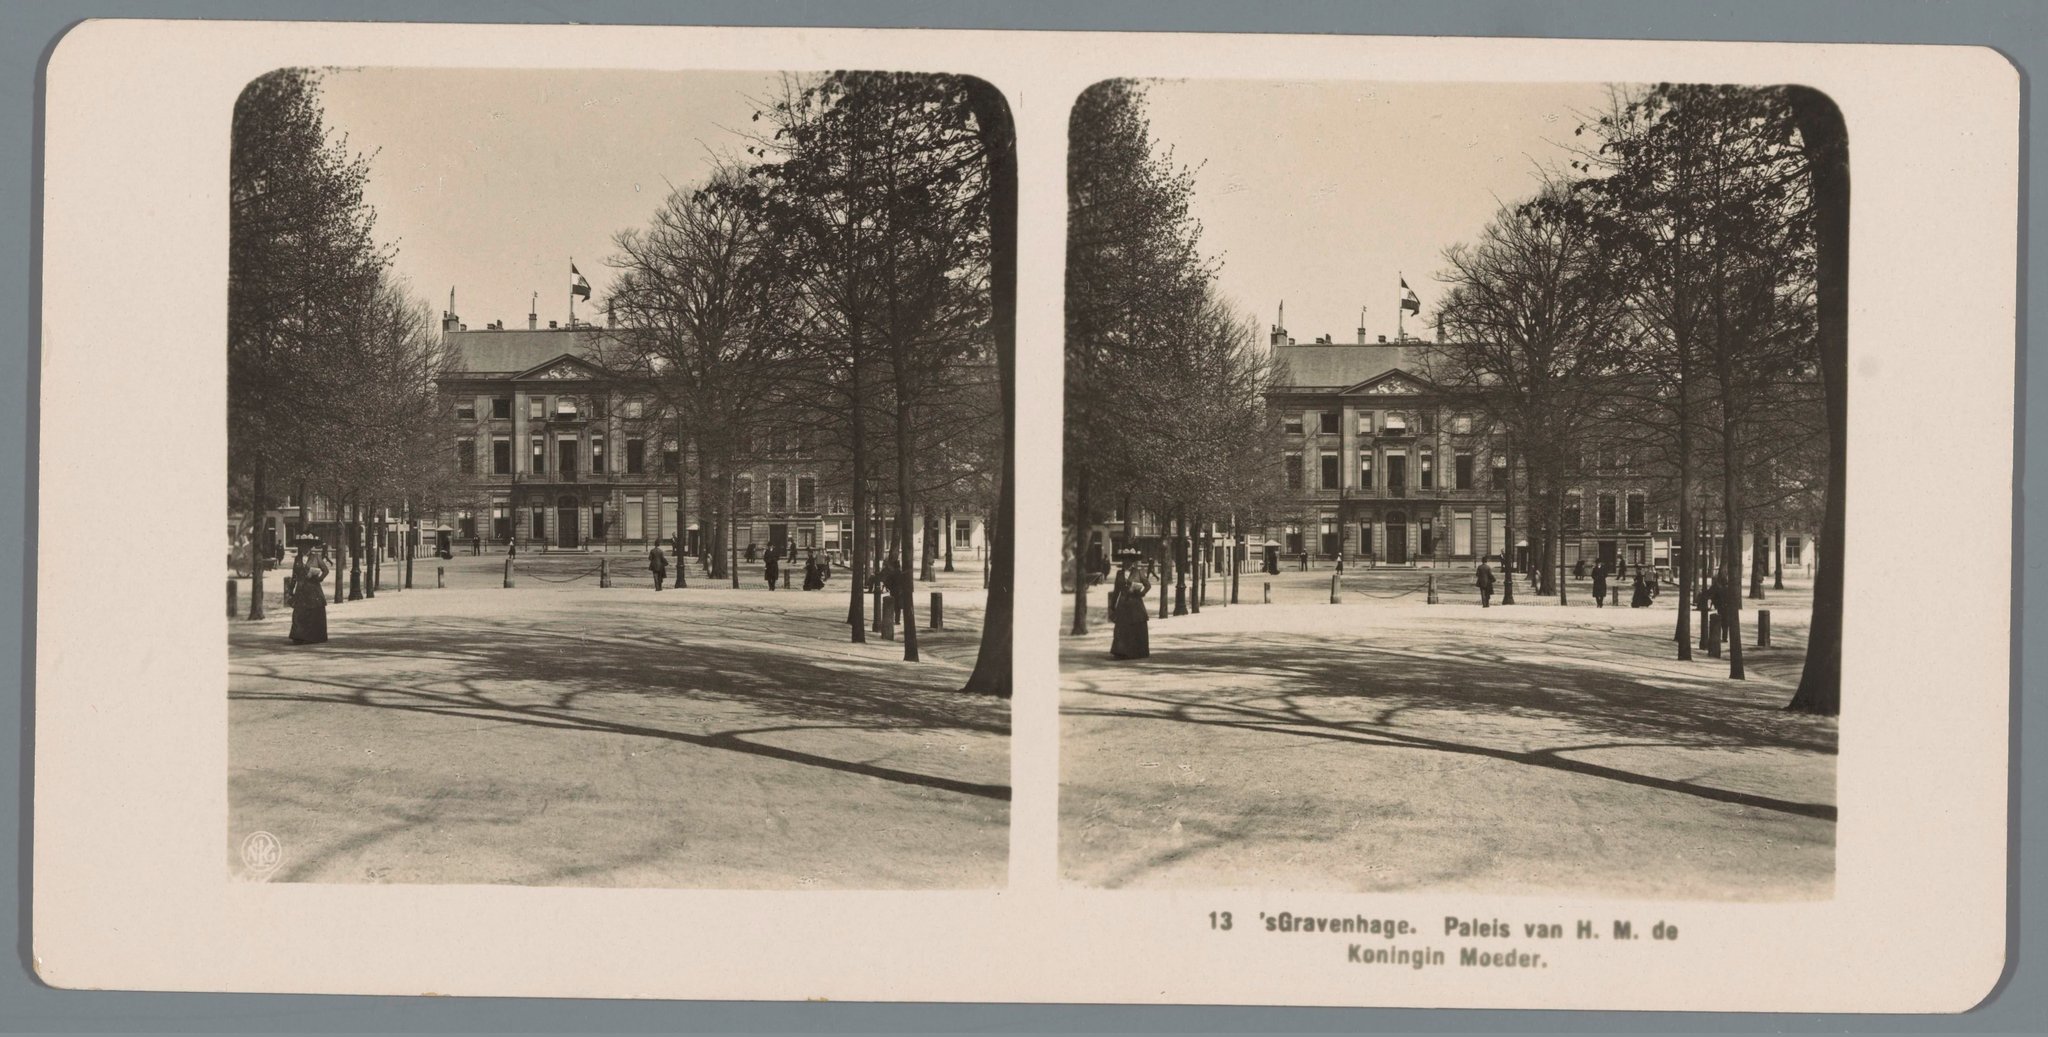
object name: stereograph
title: 's Gravenhage. Paleis van H.M. de Koningin Moeder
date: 1900-1910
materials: cardboard, photographic support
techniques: gelatin silver print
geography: the hague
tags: square, place, circus, etc., palace, façade (of house or building)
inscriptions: inscription: ‘NPG’, number: ‘13’